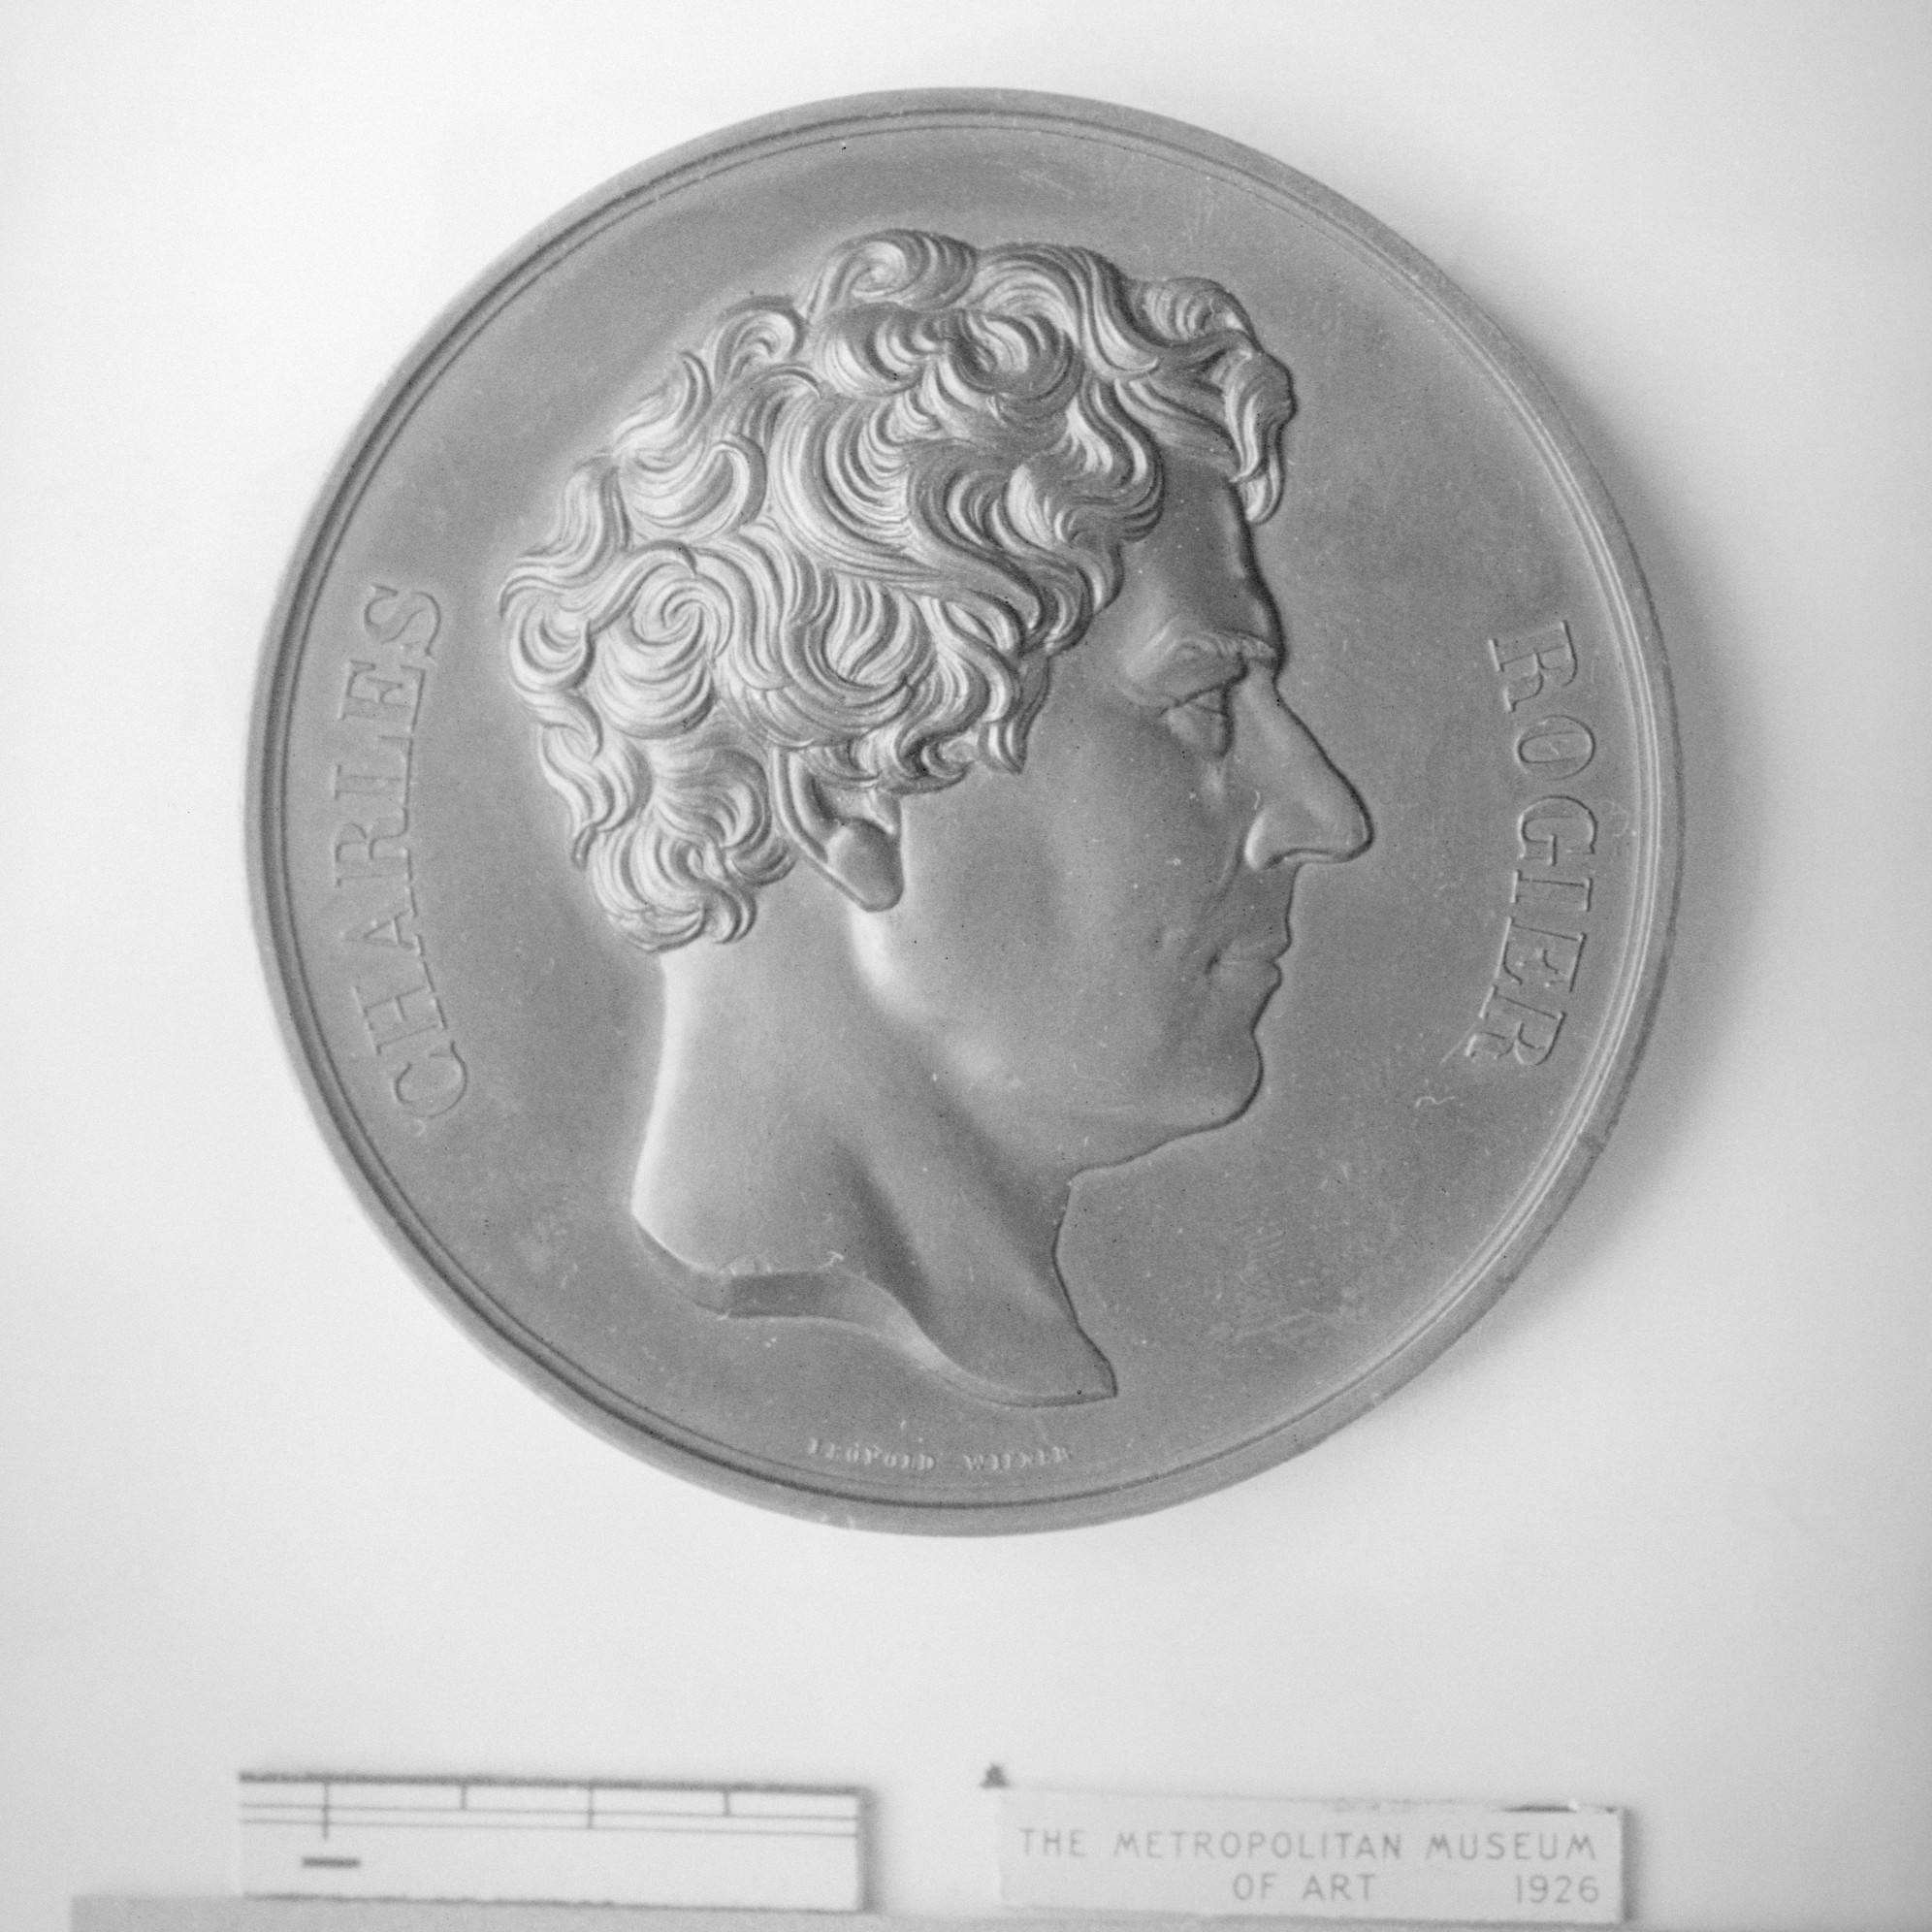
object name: medal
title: Charles Rogier, Belgian Statesman (1800–1885)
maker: leopold wiener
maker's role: artist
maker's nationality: belgian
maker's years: 1823-1891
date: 1801-1900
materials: bronze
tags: men,profiles